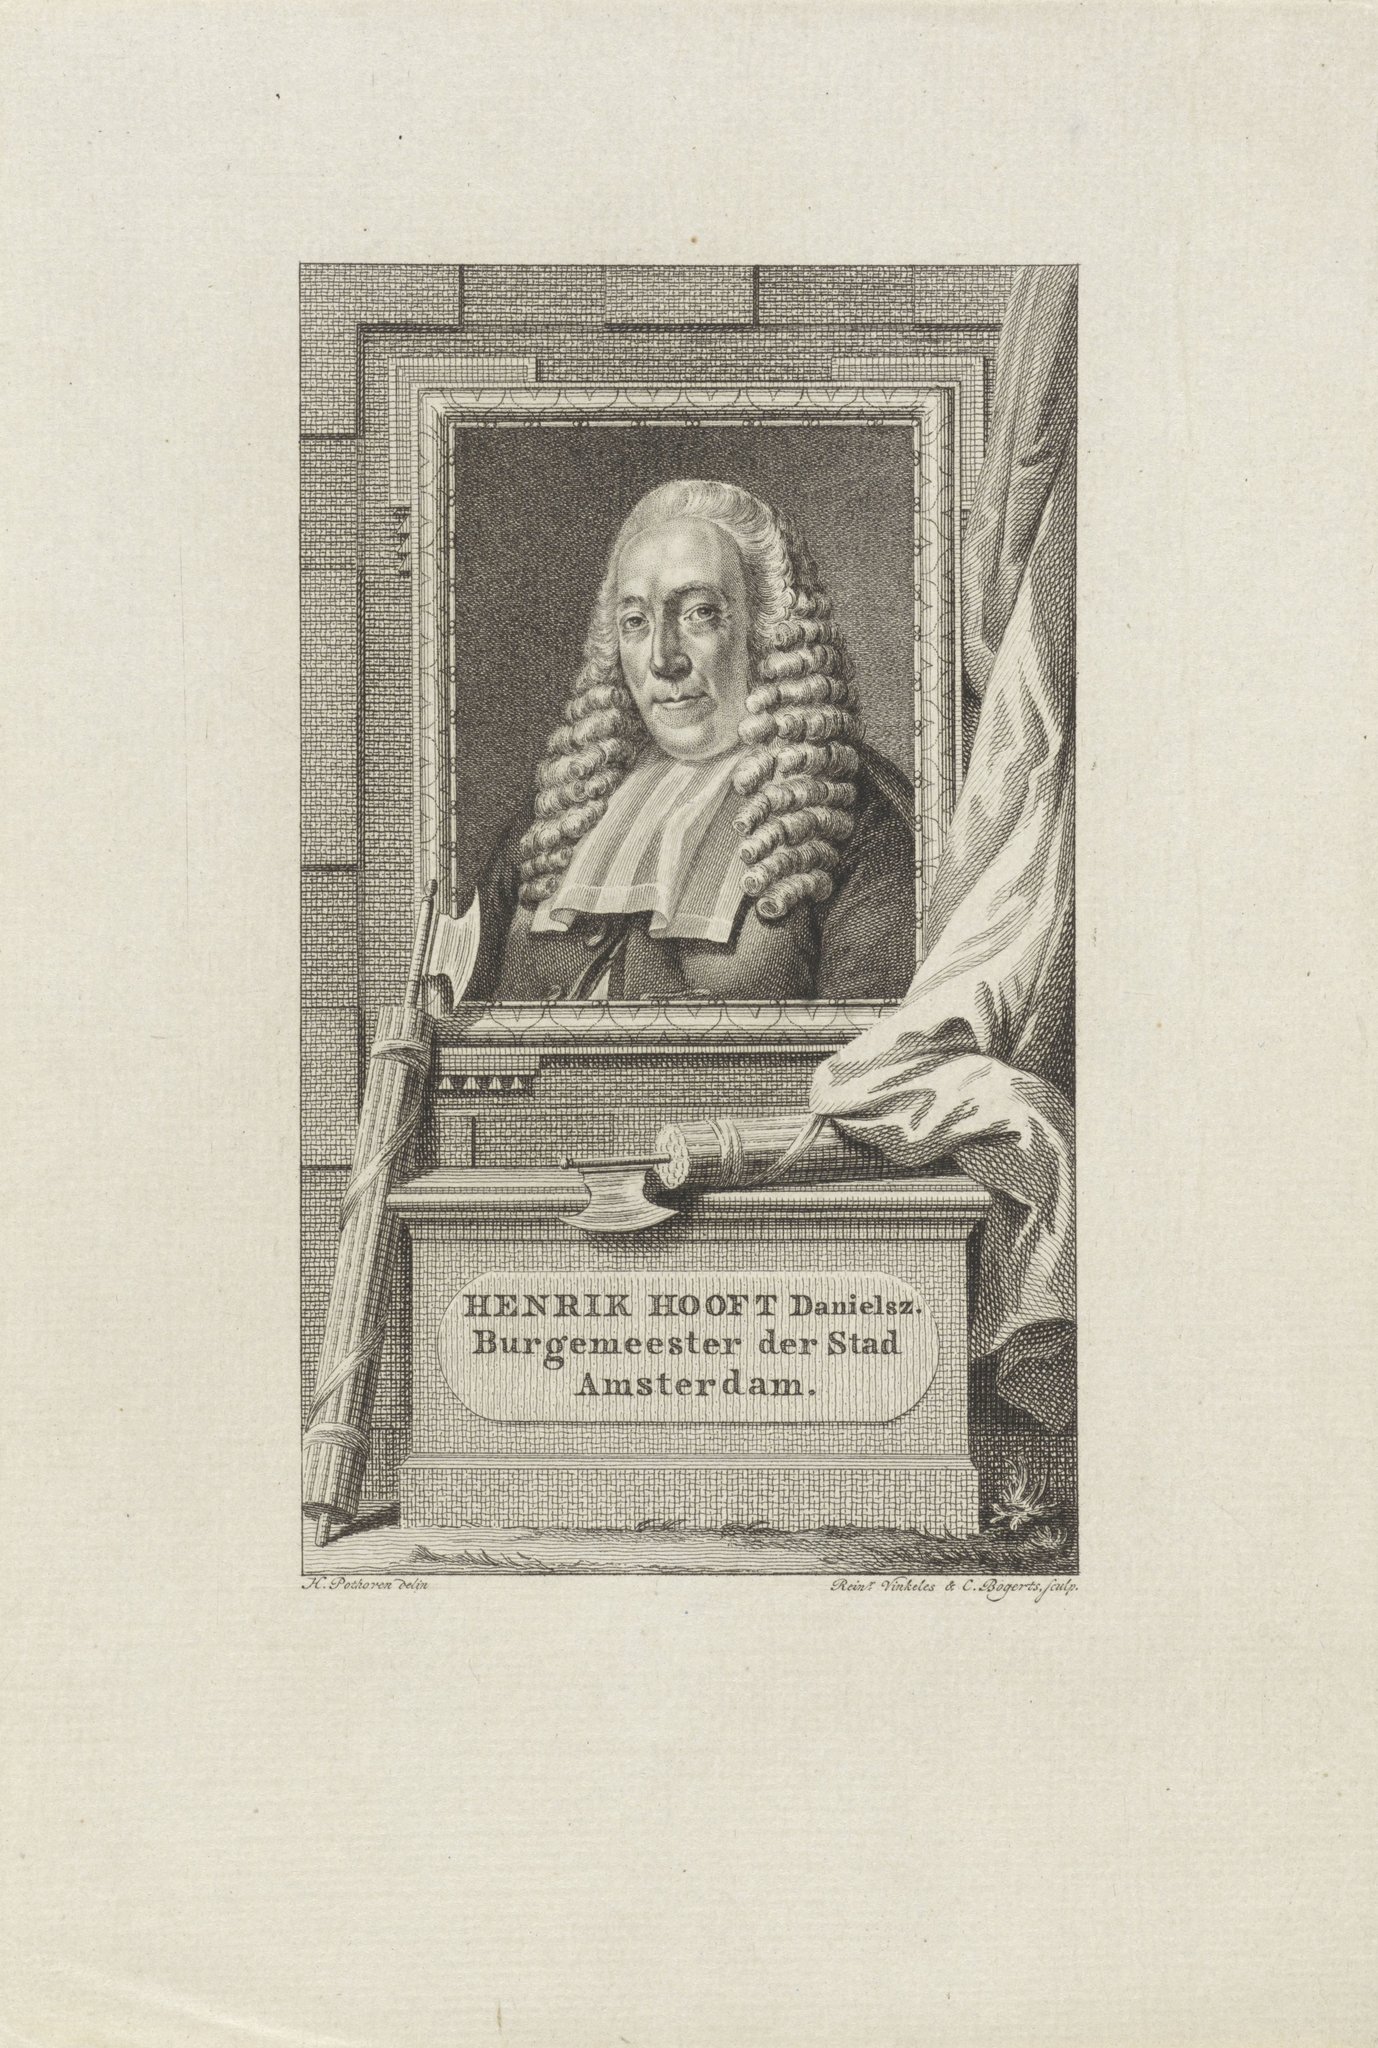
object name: print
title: Portret van Hendrik Danielsz. Hooft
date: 1786-1809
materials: paper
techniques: etching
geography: amsterdam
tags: hendrik danielsz. hooft, symbols and allegories of law; 'legge', 'legge civile' (ripa) (+ 'fasces cum securibus')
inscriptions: collector's mark: Lugt 2228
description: Prent ook gebruikt als boekillustratie in: Wagenaar, Jan. Vaderlandsche historie, (...) ten vervolge van Wagenaars Vaderlandsche historie. Dl. 1-43. Amsterdam: Johannes Allart, 1786-1809.